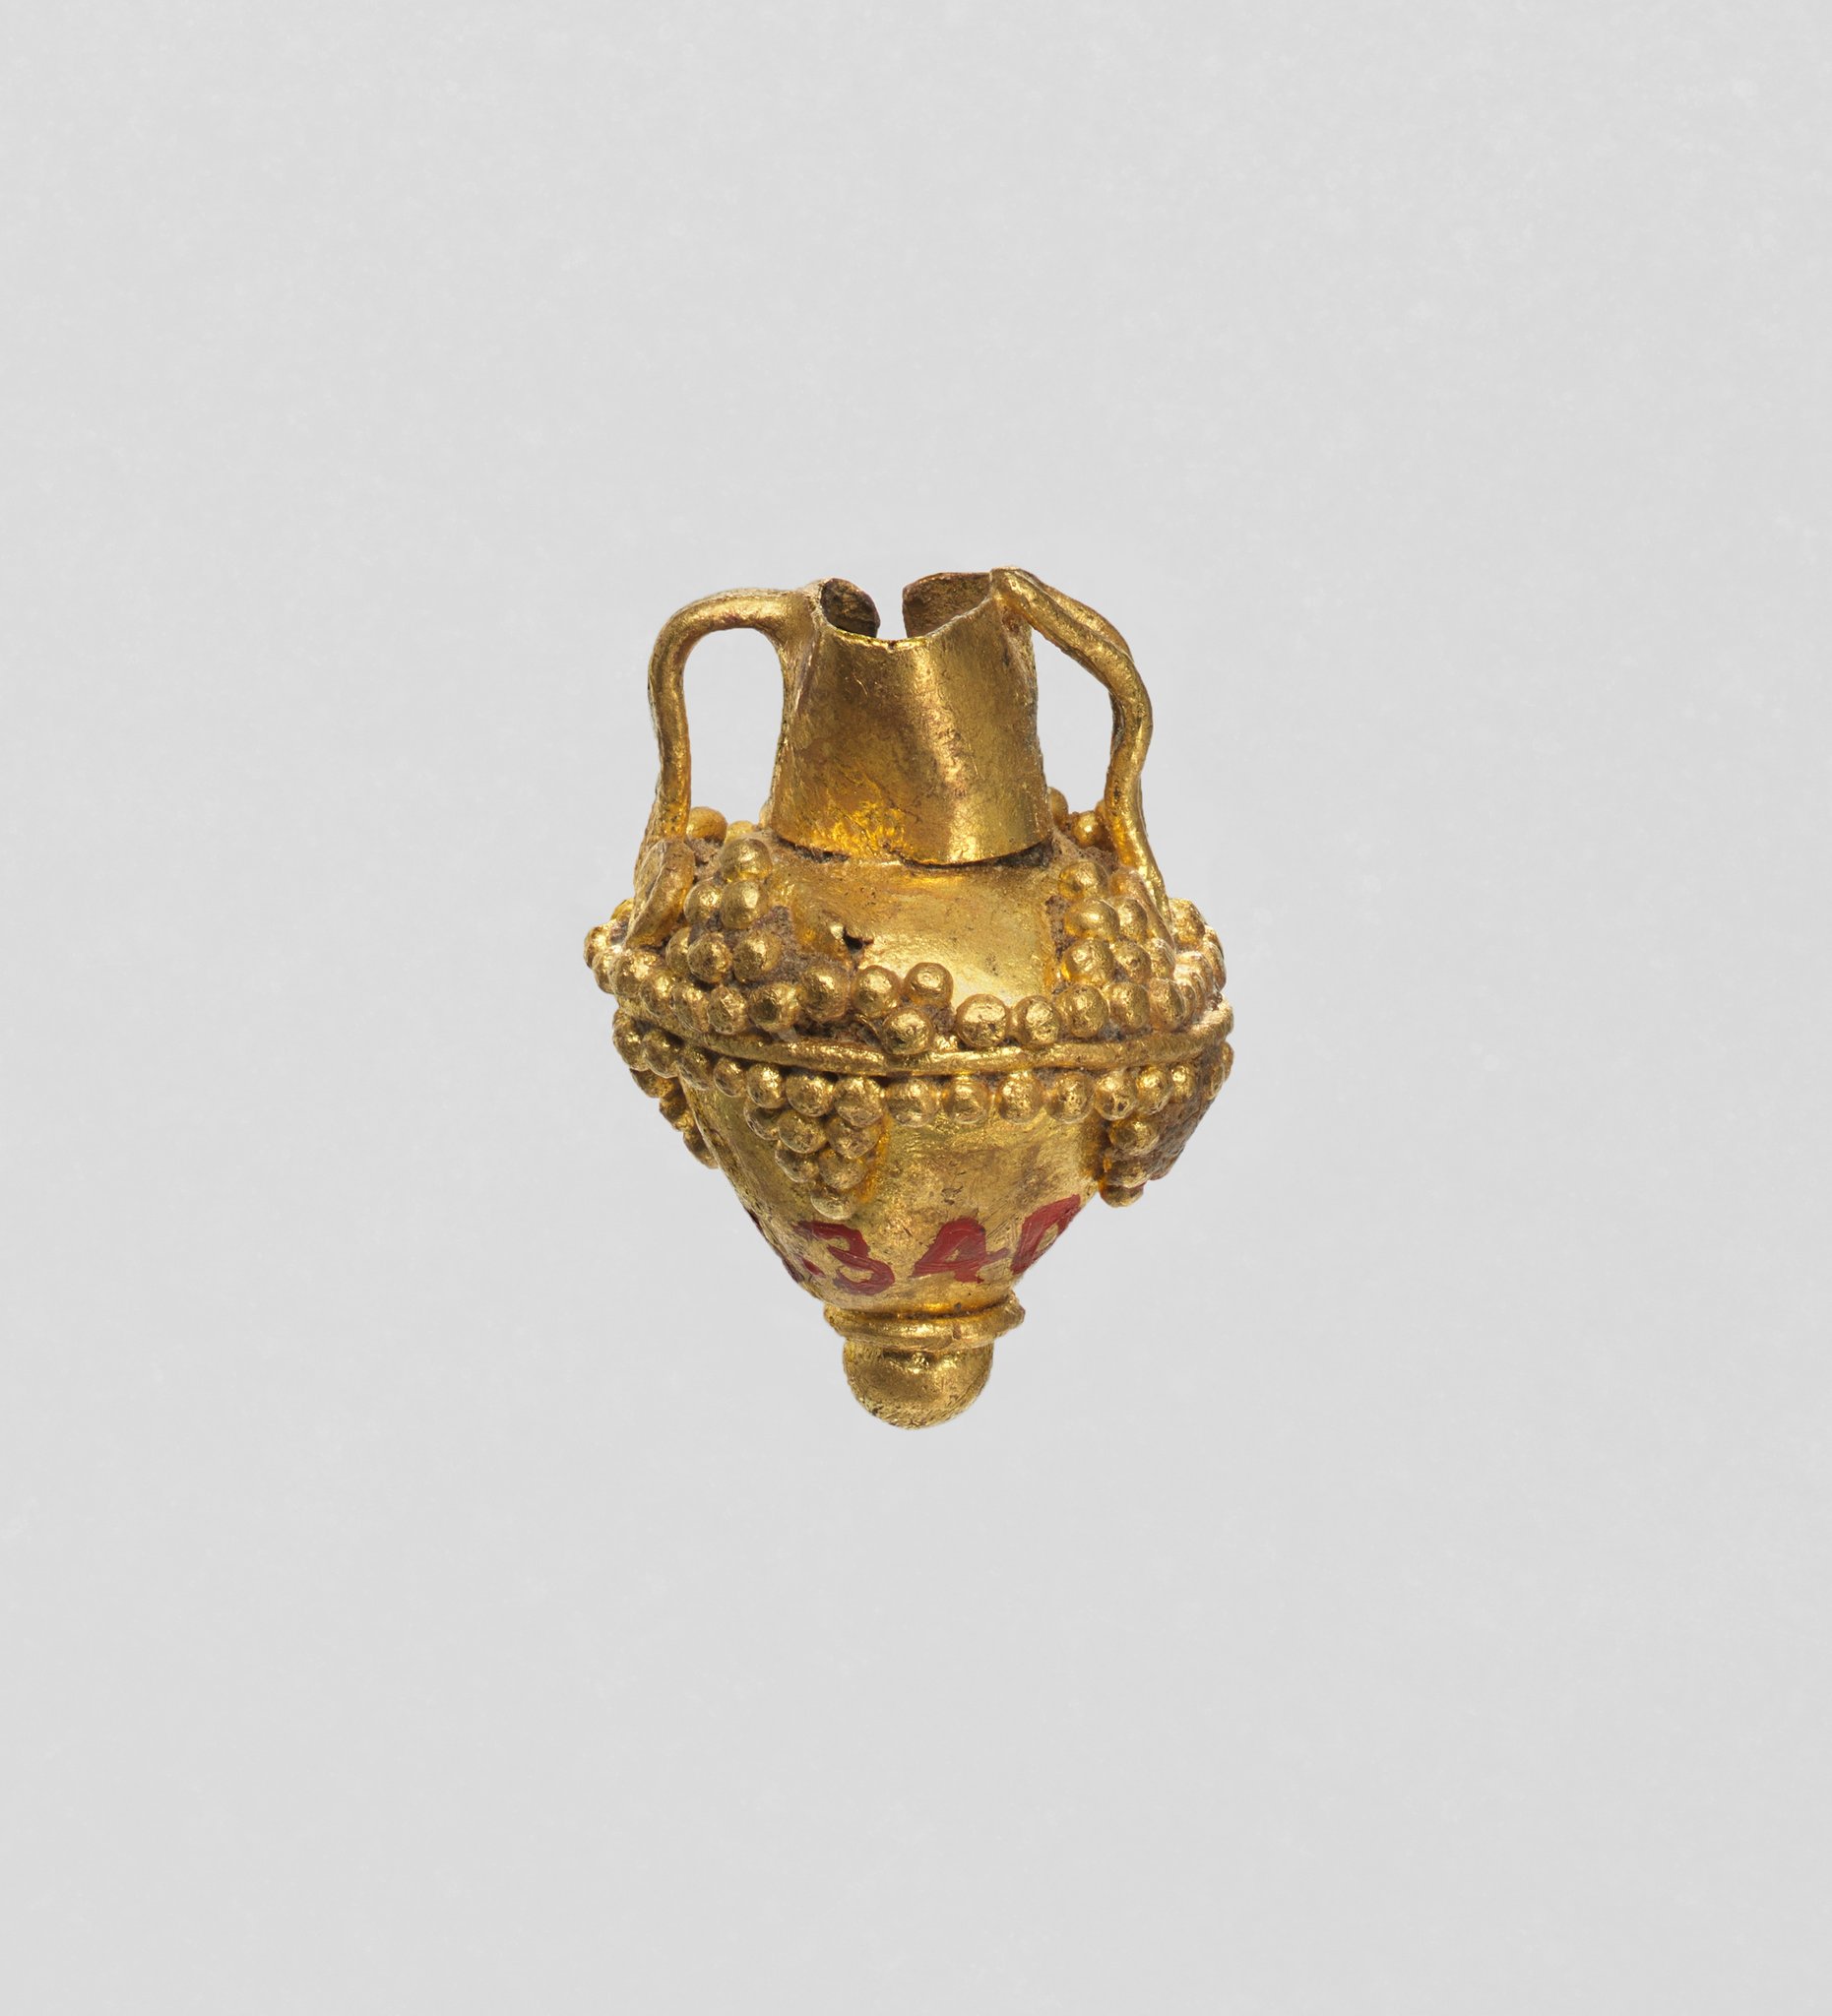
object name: pendant, amphora shape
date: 332-330 BCE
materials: gold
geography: egypt